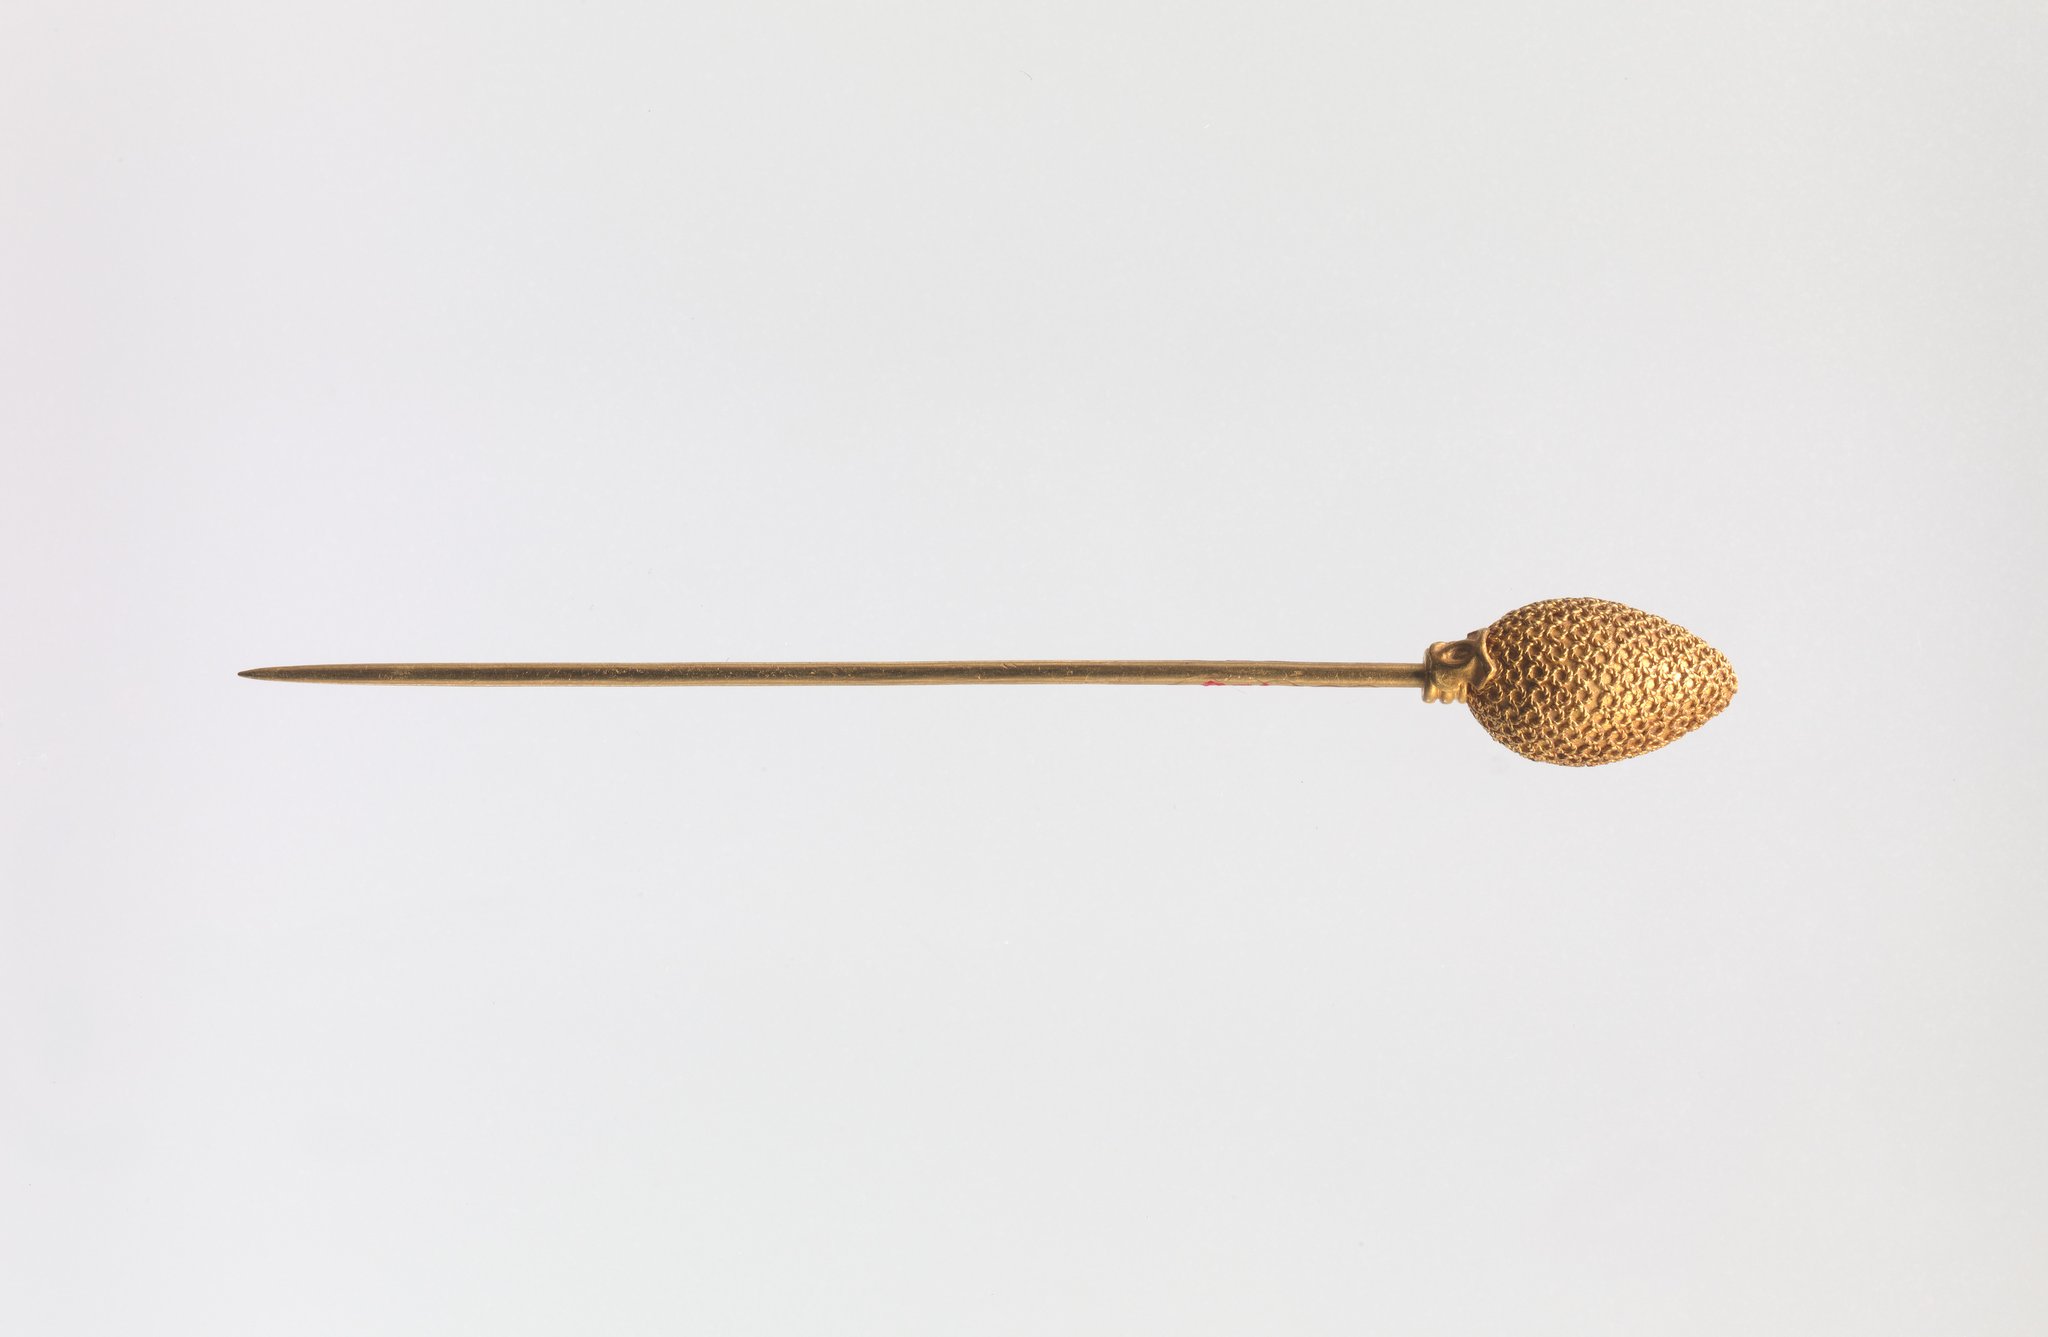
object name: cravat pin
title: Archeological-revival cravat pin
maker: castellani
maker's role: maker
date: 1880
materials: gold, steel